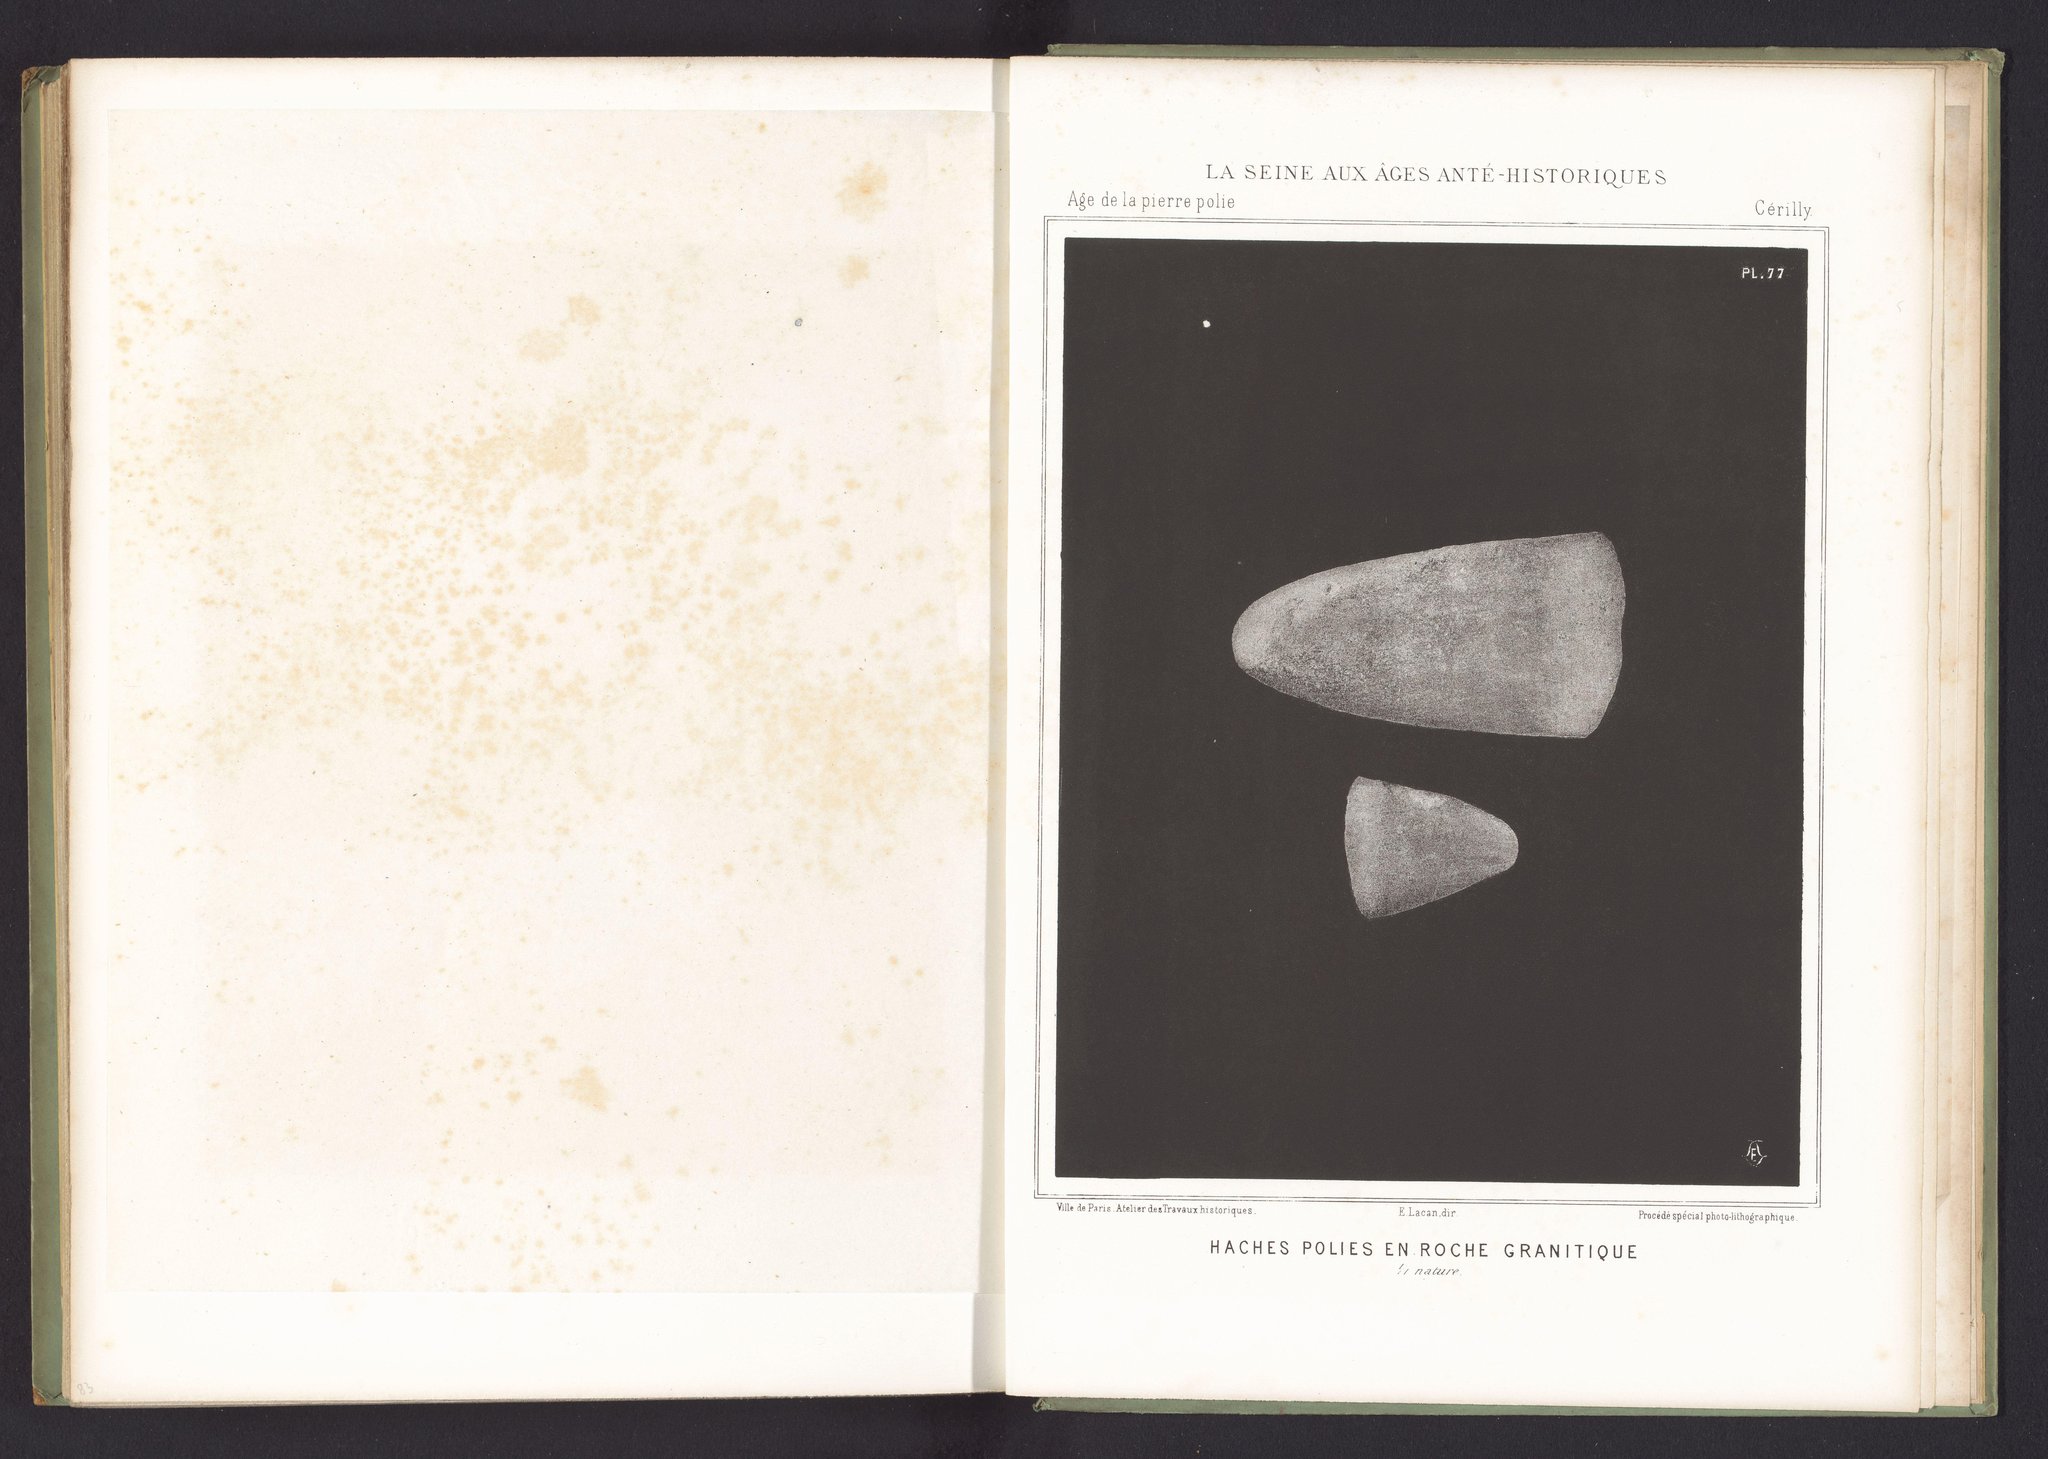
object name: page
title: HACHES POLIES EN ROCHE GRANITIQUE 1/1 nature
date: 1860-1869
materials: paper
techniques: photolithography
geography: paris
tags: animals (+ skeleton of an animal), palaeontology, france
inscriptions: monogram: ‘LEL’, number: ‘Pl. 77’, inscription: ‘Ville de Paris. Atelier des Travaux historiques. E. Lacan, dir. Procédé spécial photo-lithographique.’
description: Voor plek prent in boek: zie nummer onder 'Opschriften / Merken'.